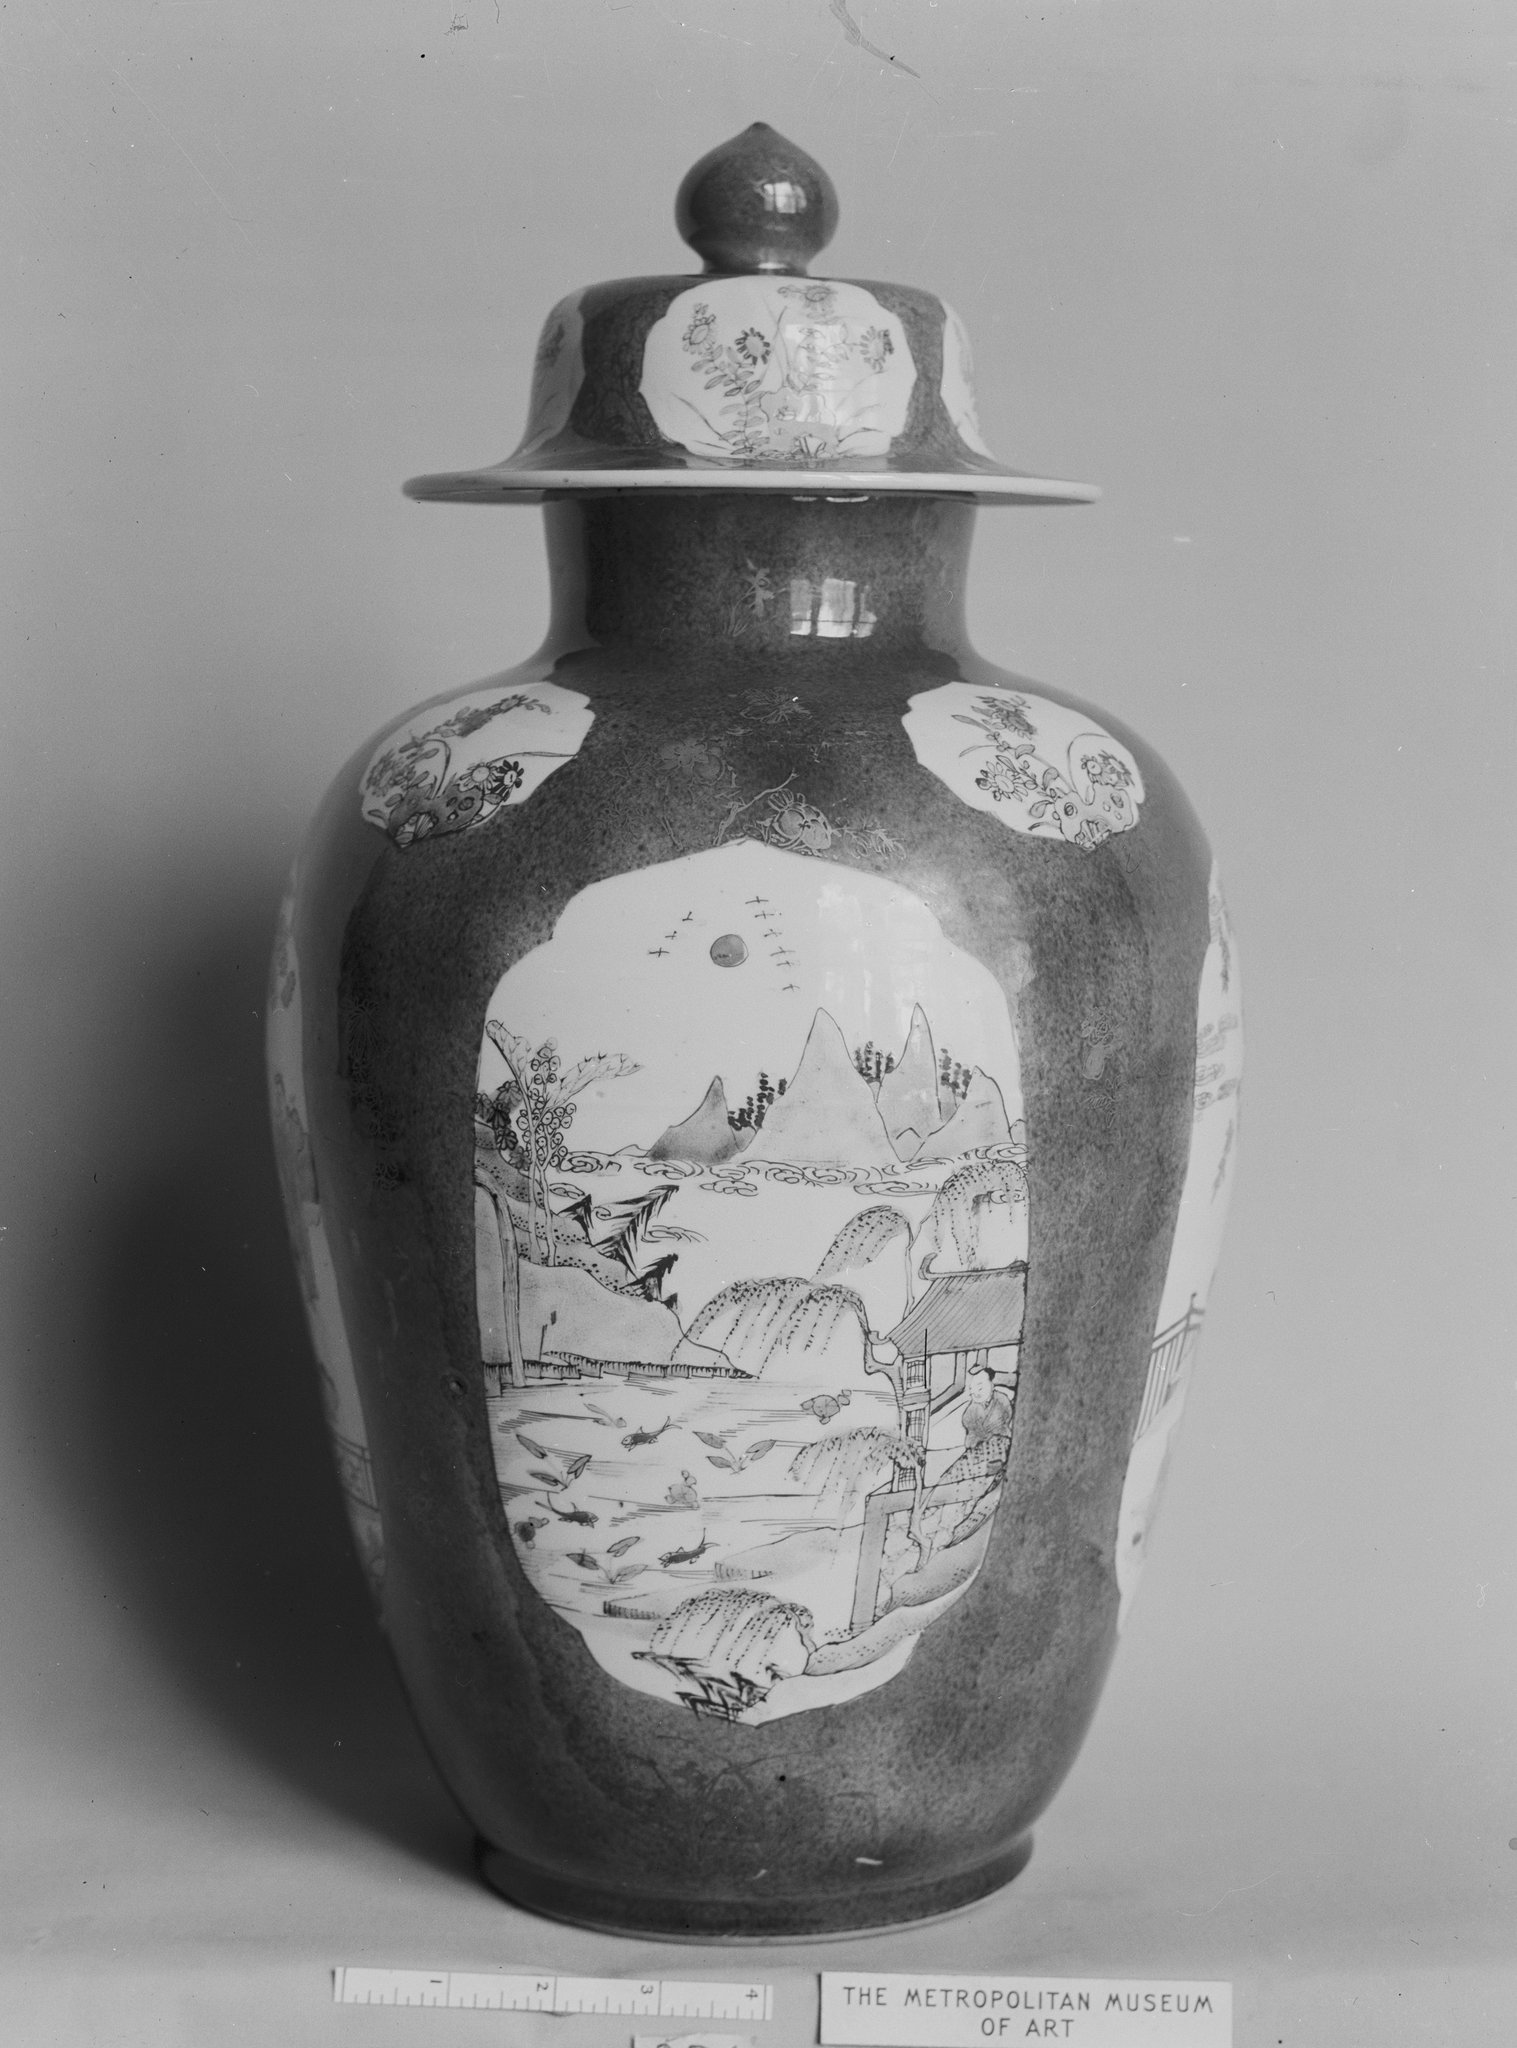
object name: covered jar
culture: chinese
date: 1662-1722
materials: enamel, porcelain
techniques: painting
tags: human figures,fish,mountains,landscapes